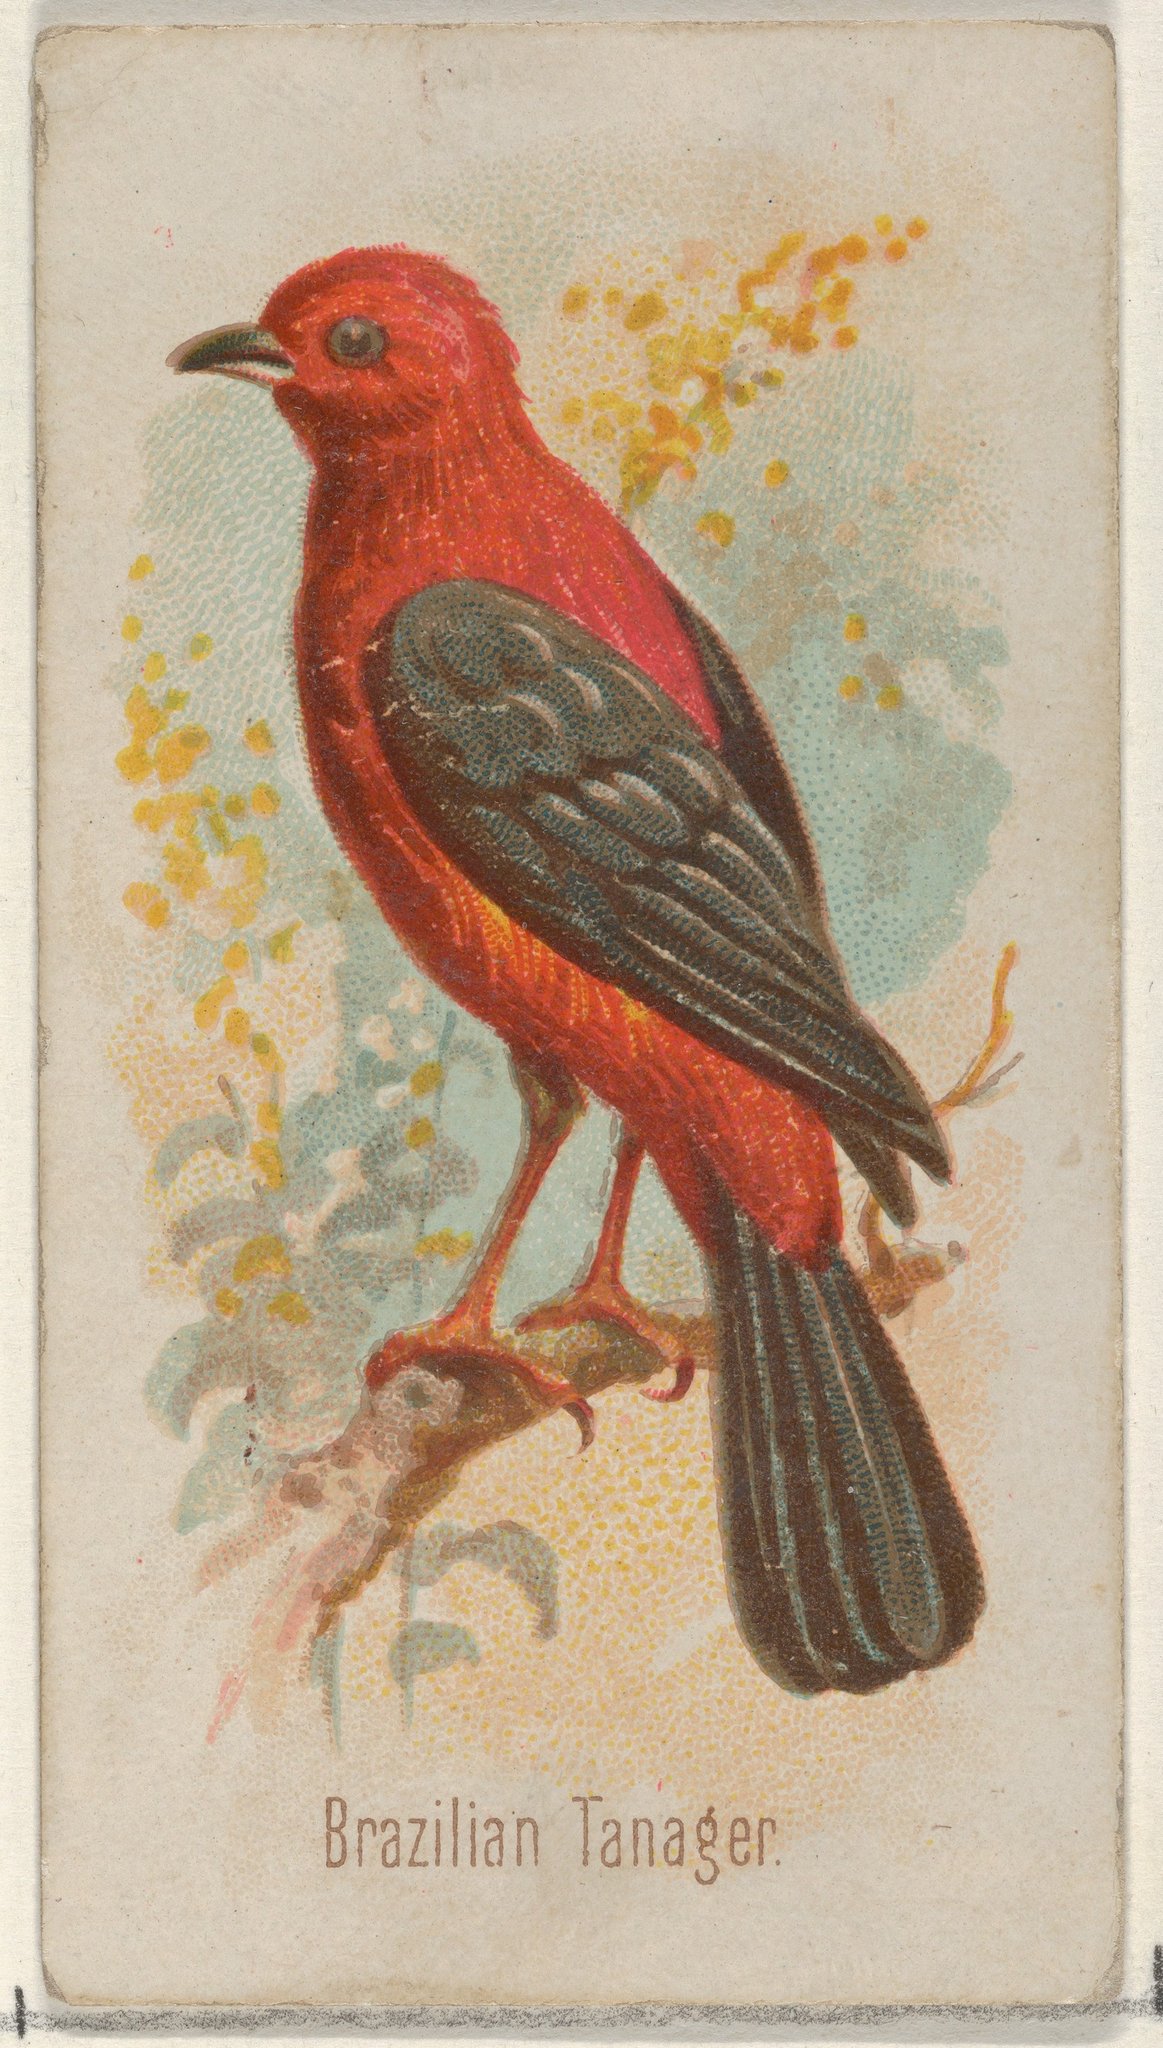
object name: print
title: Brazilian Tanager, from the Song Birds of the World series (N23) for Allen & Ginter Cigarettes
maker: allen & ginter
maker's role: publisher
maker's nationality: american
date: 1890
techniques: color lithograph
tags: birds